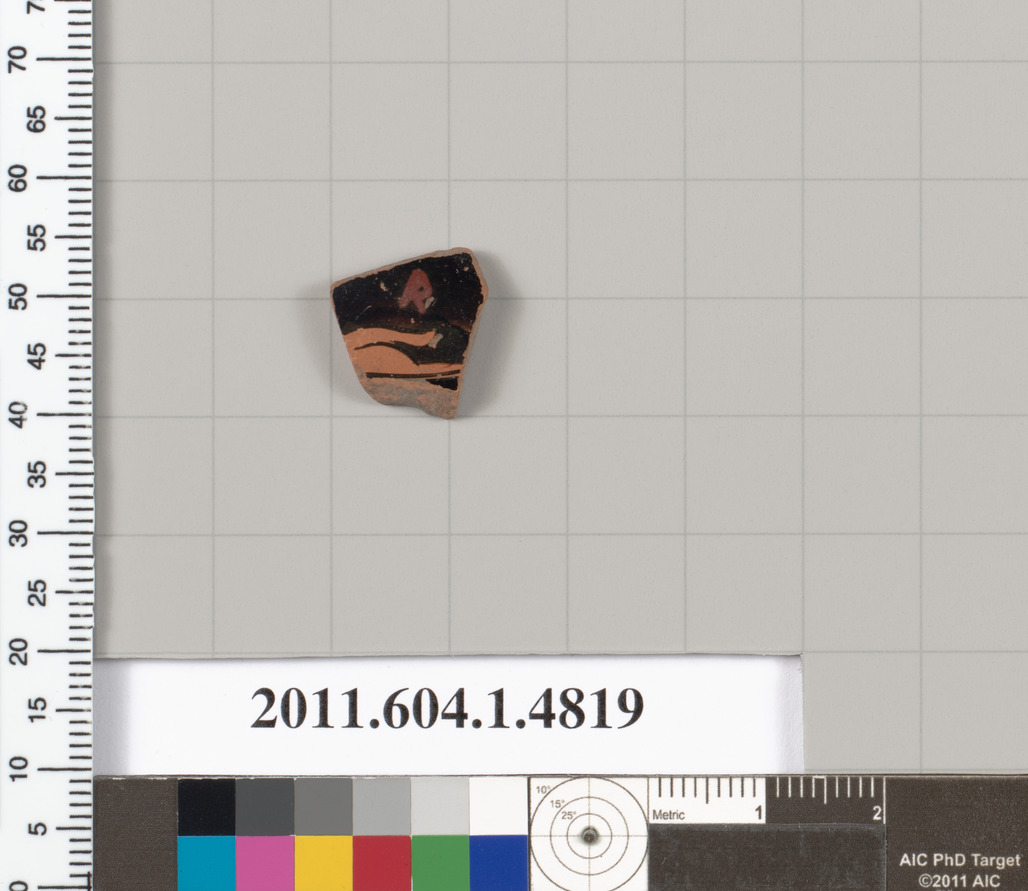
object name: kylix fragment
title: Terracotta fragment of a kylix (drinking cup)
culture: greek, attic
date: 520-500 BCE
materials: terracotta